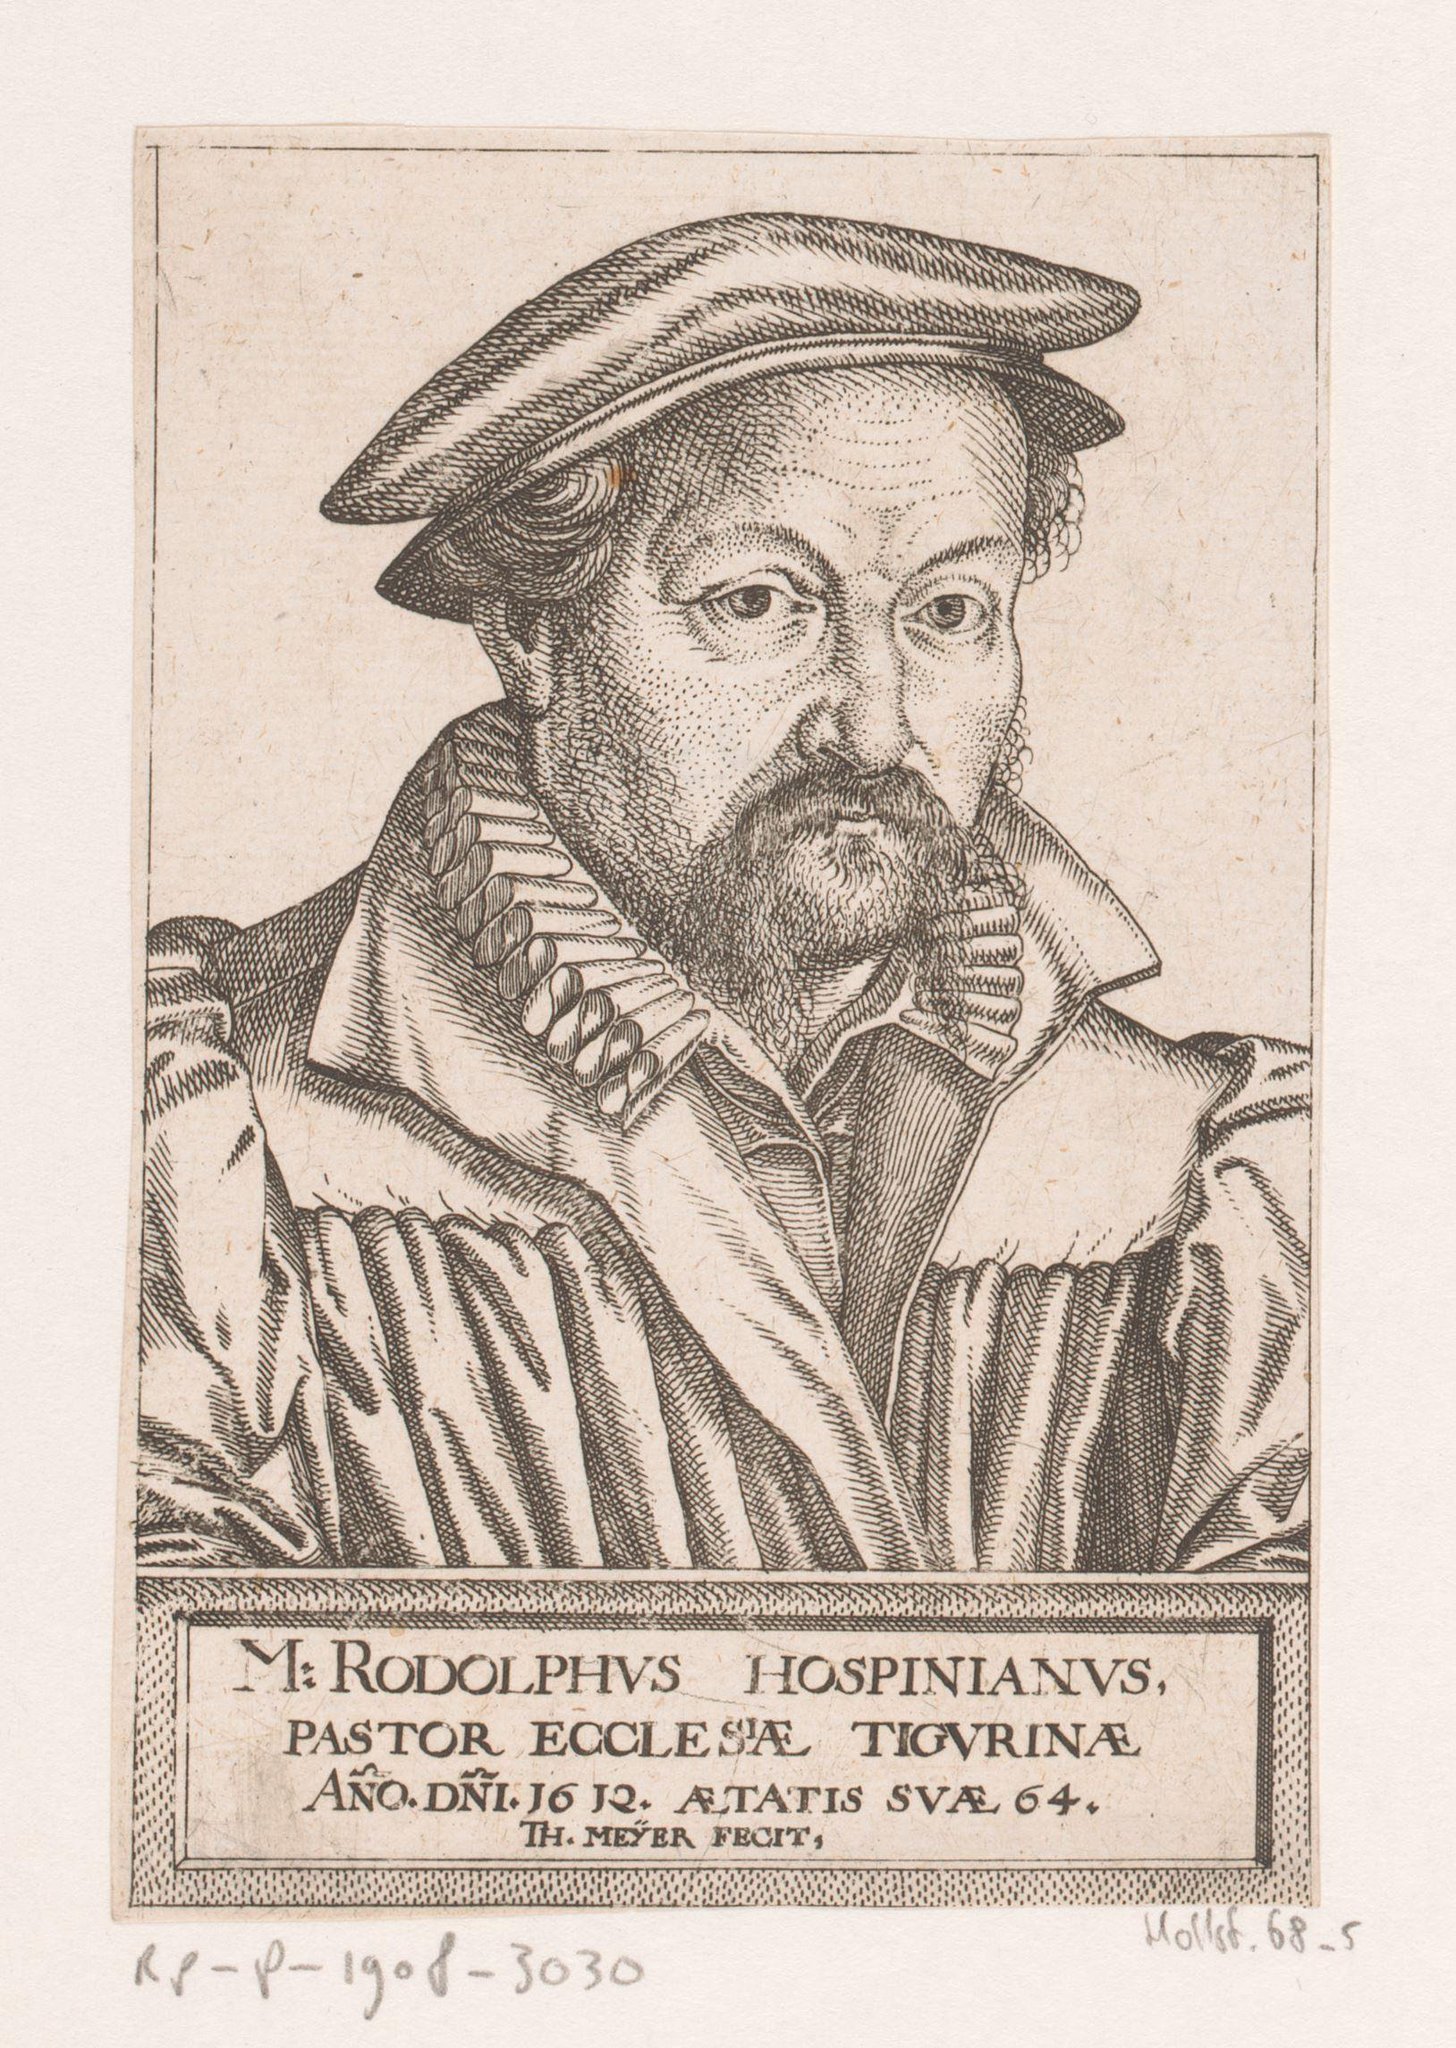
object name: print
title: Portretten van priesters en theologen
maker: dietrich meyer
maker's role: painter, print maker, publisher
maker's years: 1572-1658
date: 1612-1658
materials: paper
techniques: engraving, etching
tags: pfäffikon, theologian, historical persons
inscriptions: collector's mark: Lugt 2228